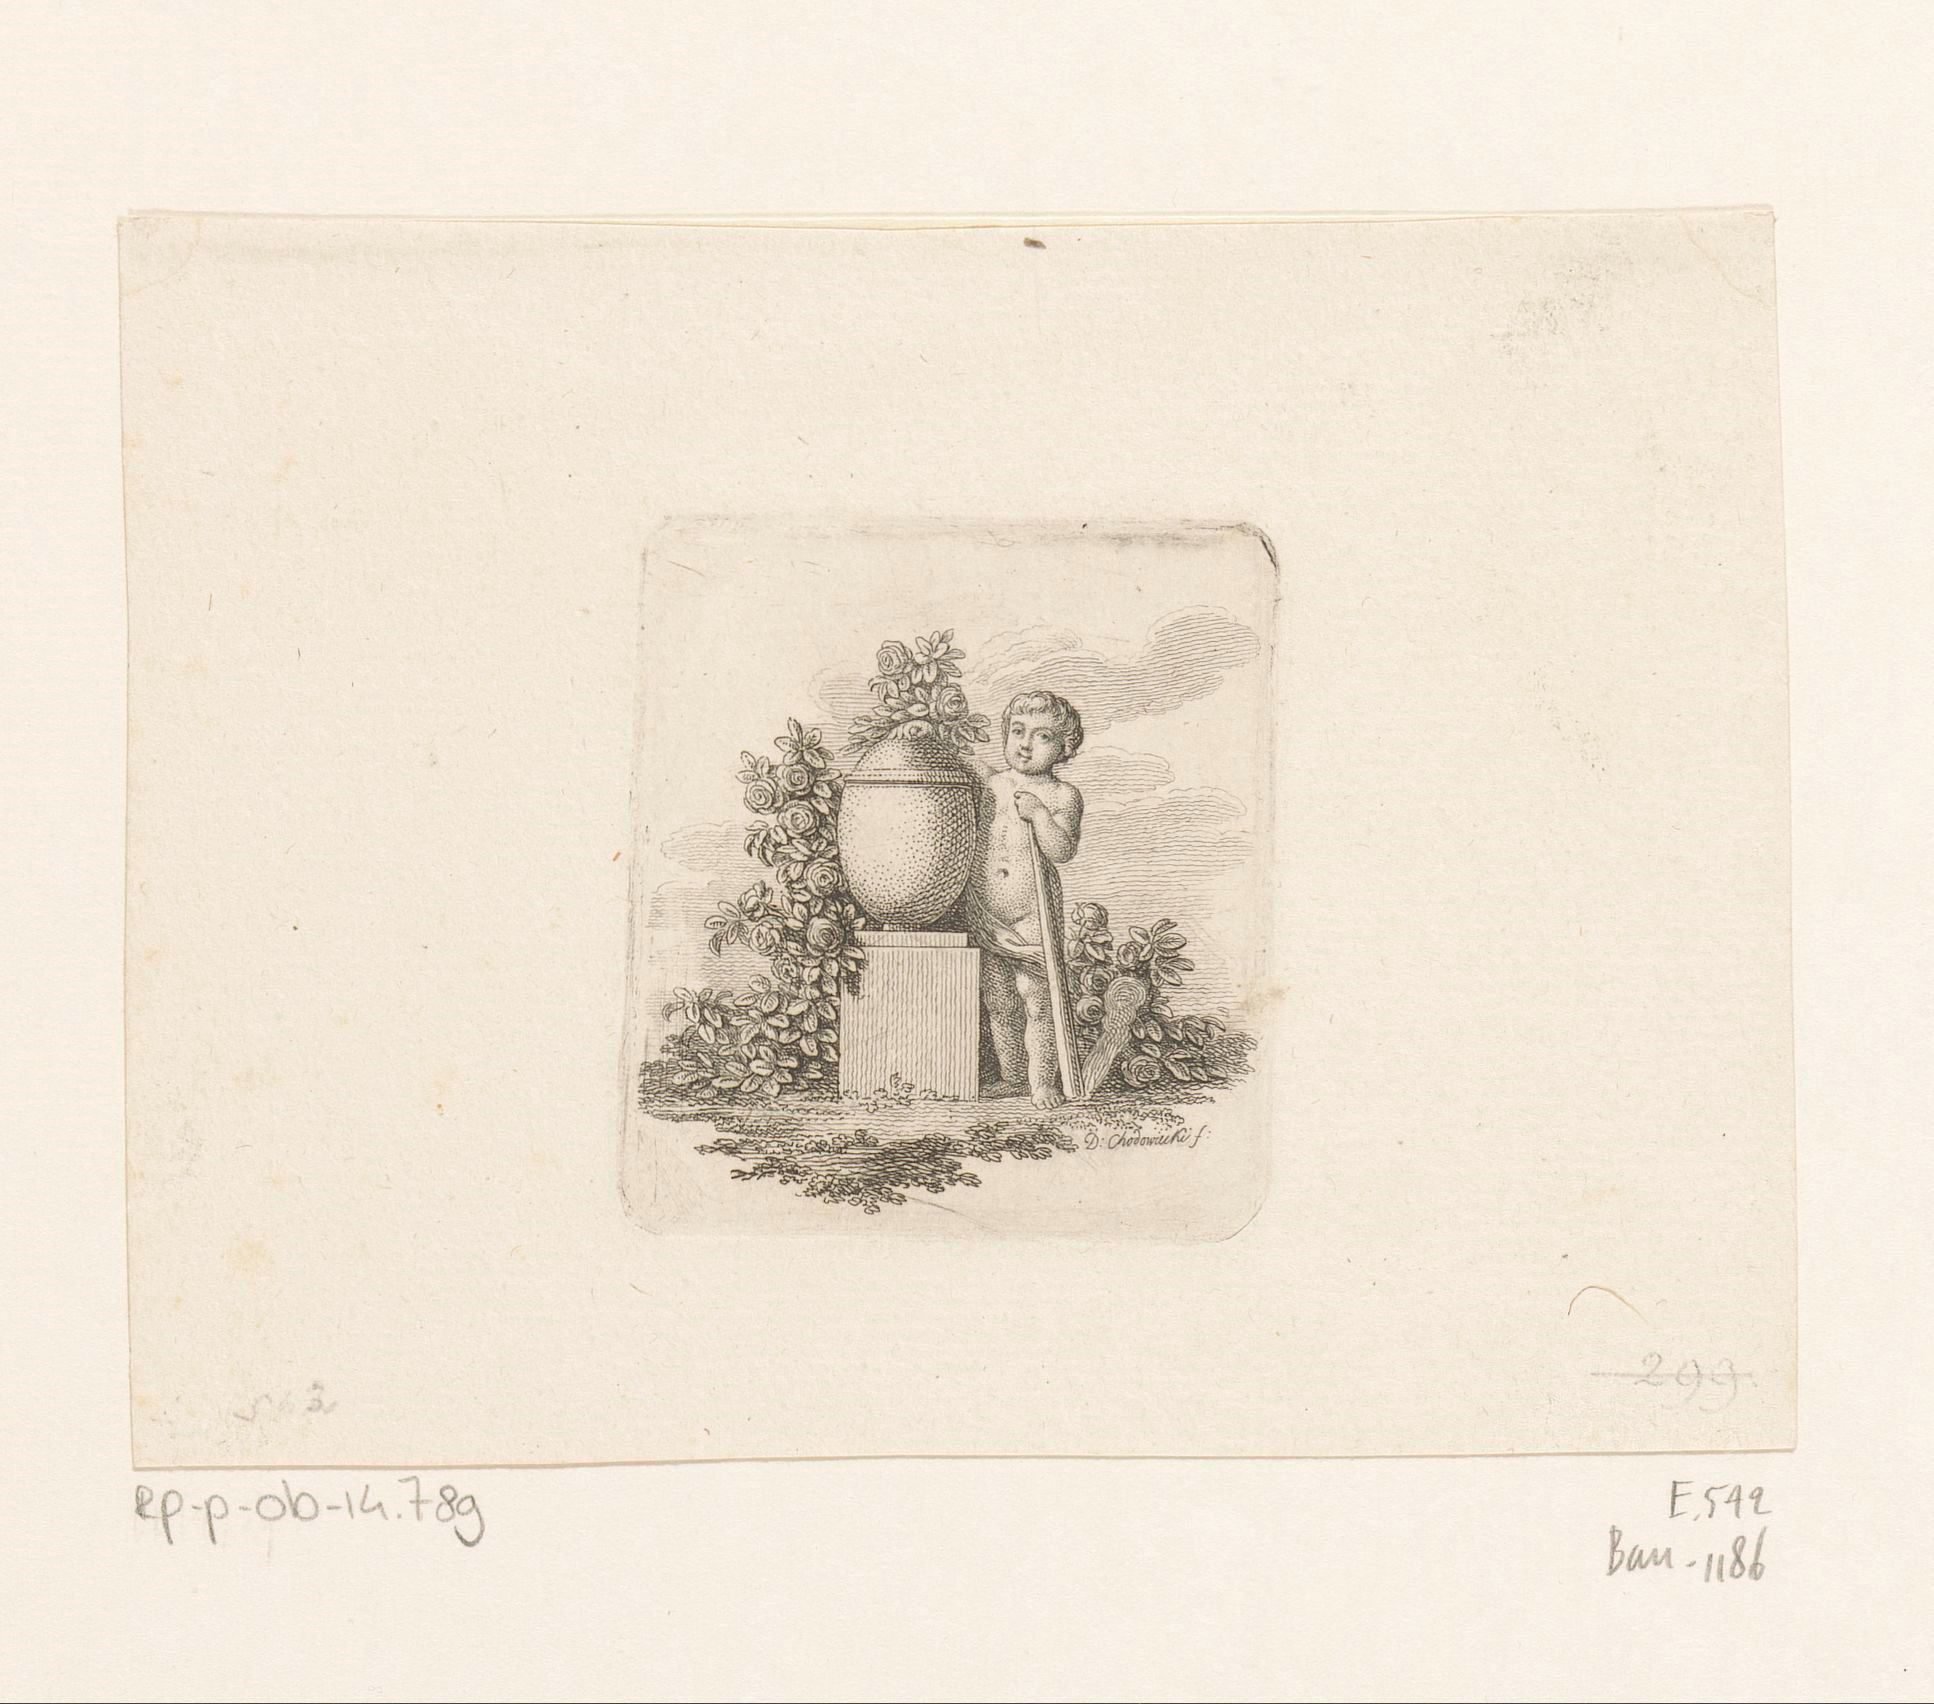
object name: print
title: Putto naast een urn, leunend op een omgekeerde fakkel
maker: daniel nikolaus chodowiecki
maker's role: draughtsman, print maker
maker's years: 1726-1801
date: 1785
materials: paper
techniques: etching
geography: berlin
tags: torch - bb - torch held upside down, personifications of death; 'morte' (ripa), urn, cupids: 'amores', 'amoretti', 'putti'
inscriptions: collector's mark: Lugt 2228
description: Prent gebruikt voor: Karschin, Anna Luise. Der Nachruhm am Begräbnisstage meiner seligen Freundin ihrem Chodowiecky. Berlijn: G. J. Decker, 1785. Uitgegeven naar aanleiding van het overlijden van de vrouw van Daniel Nikolaus Chodowiecki.